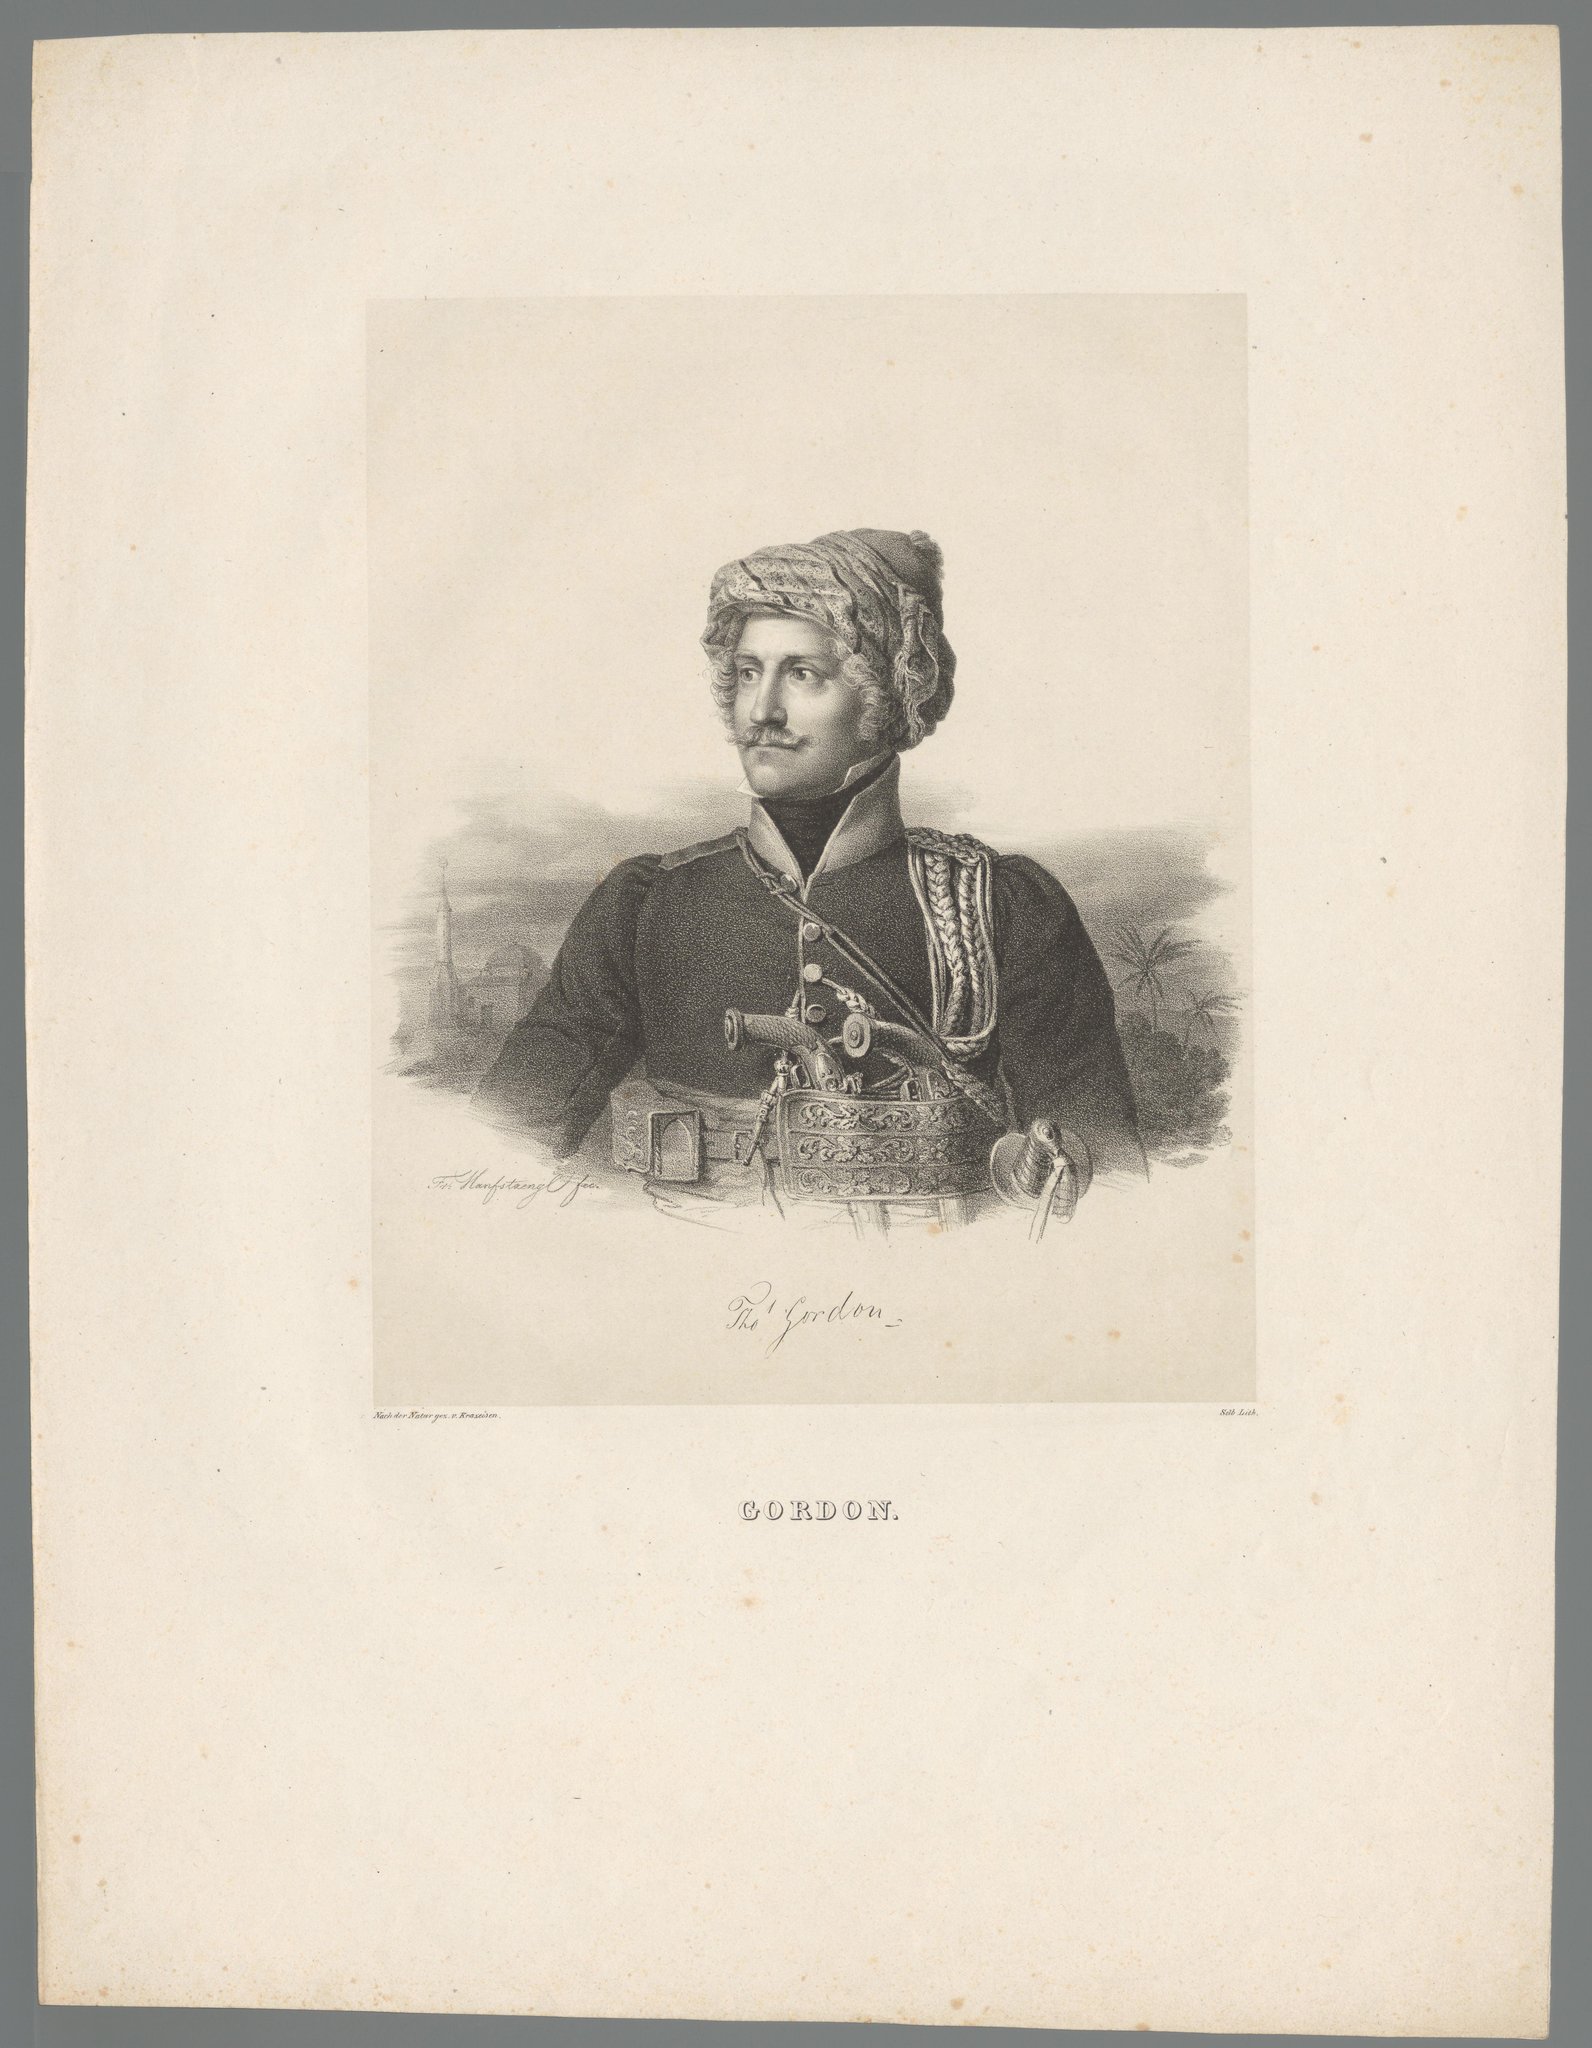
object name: print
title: Gordon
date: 1814-1877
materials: paper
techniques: tone lithography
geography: munich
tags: moustache, adult man, historical persons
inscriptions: collector's mark: Lugt 2228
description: De prent hoort mogelijk bij een serie prenten met portretten van betrokkenen bij de Griekse onafhankelijkheidsoorlog. Mogelijk de serie: Bildnisse ausgezeichneter Greichen und Philhellene nebst einigen Ansichten und Trachten.